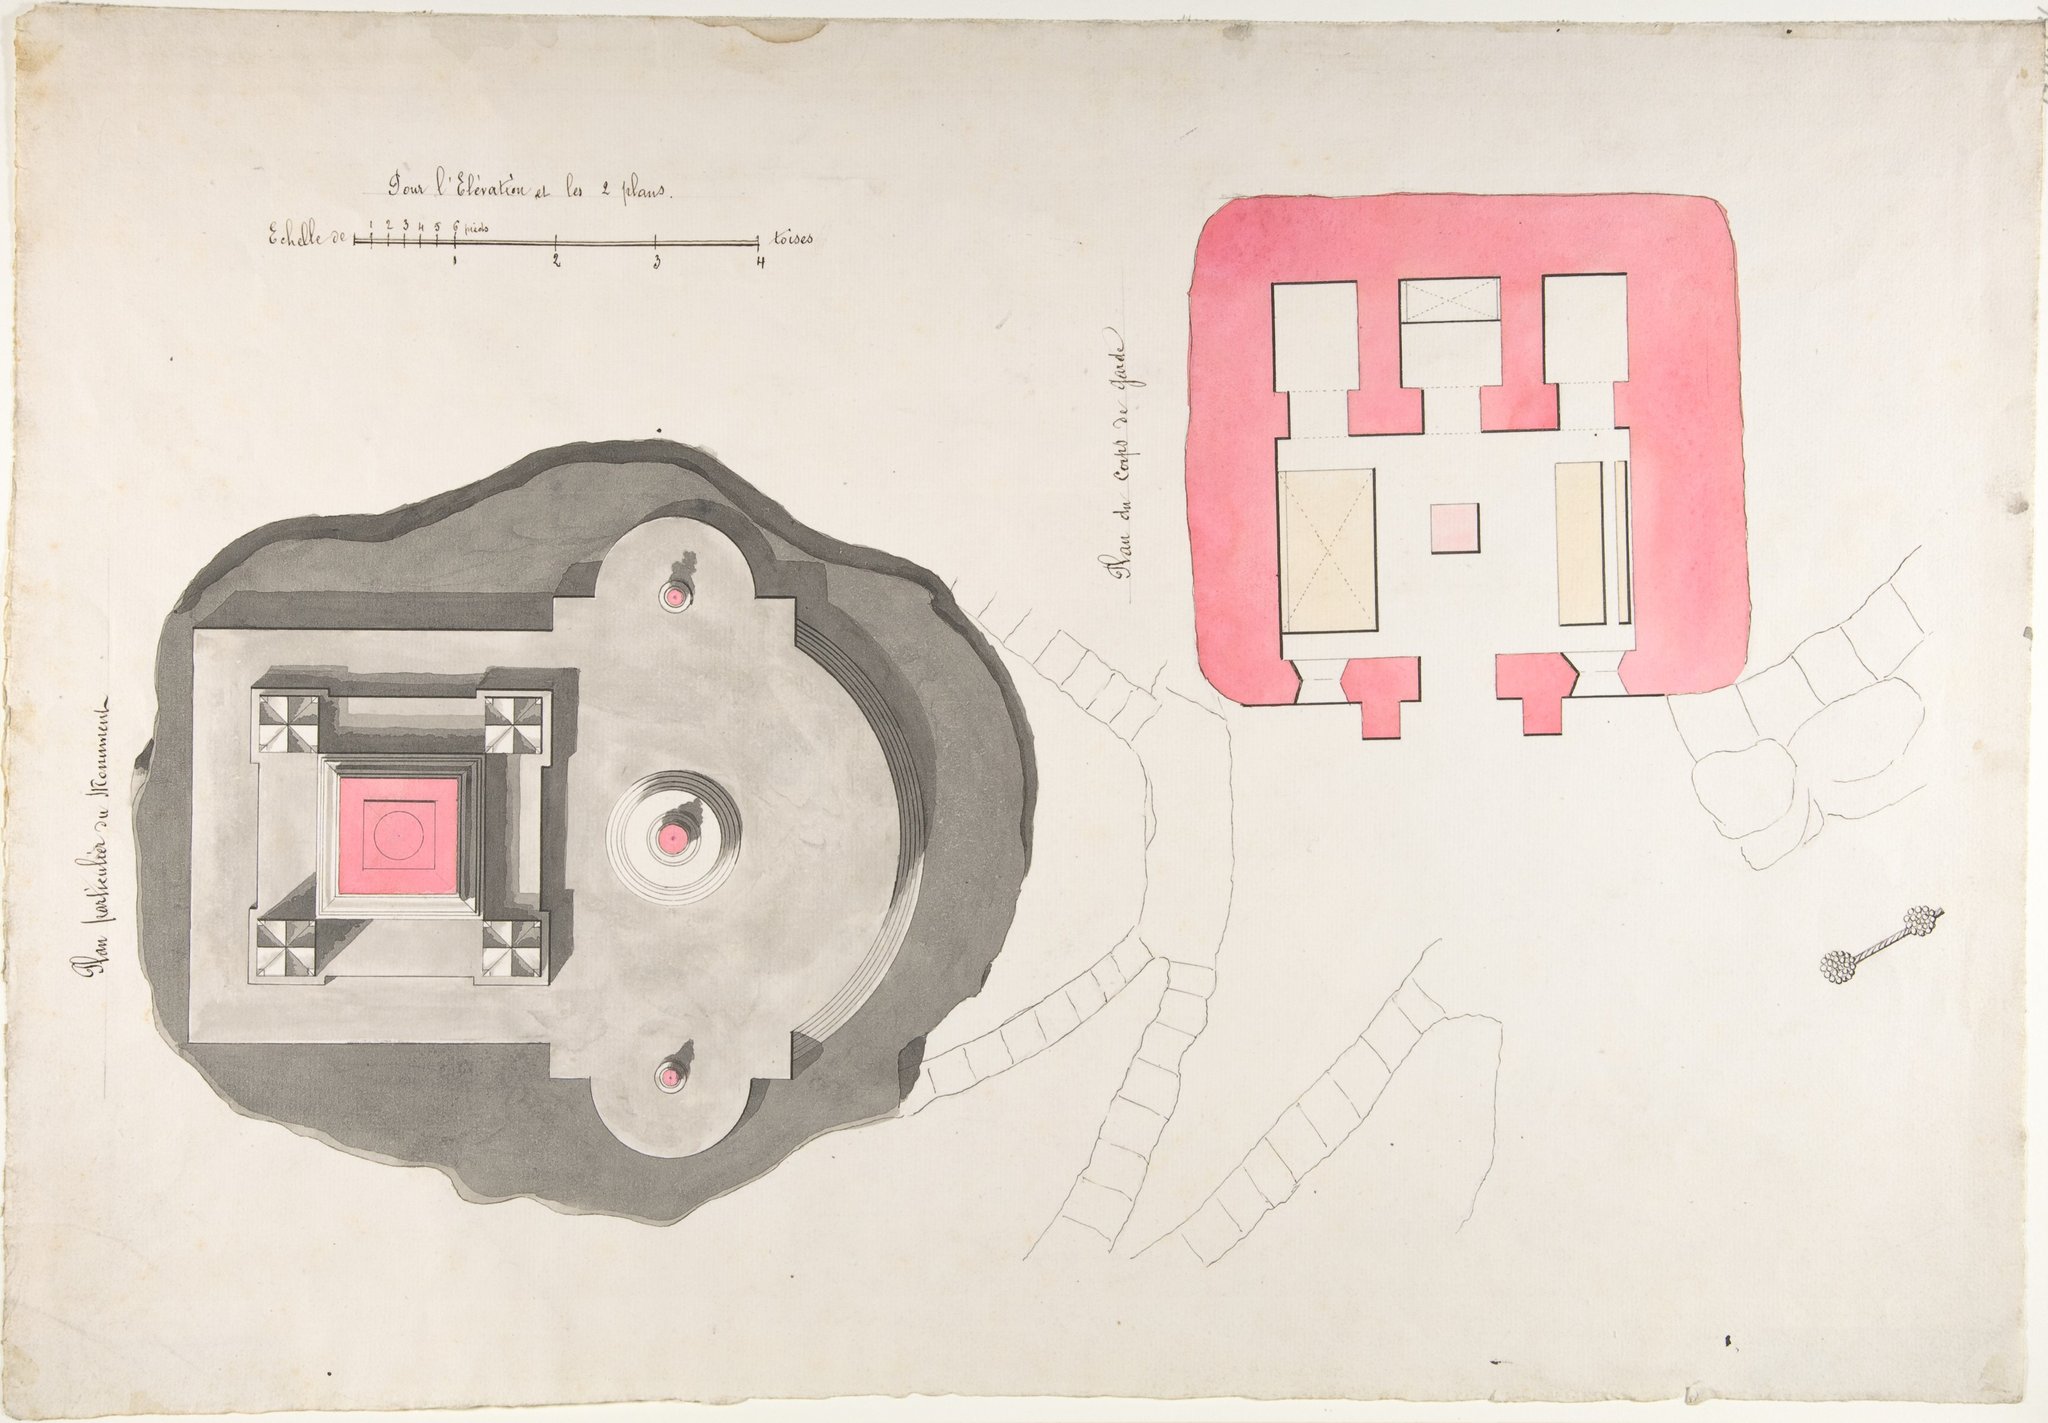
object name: drawing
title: Project for the Monument de la Montagne, Orléans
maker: claude mathieu delagardette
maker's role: artist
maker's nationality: french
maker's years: 1765-1805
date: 1794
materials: graphite, ink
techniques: brush, pen, drawing, wash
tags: architecture,monuments